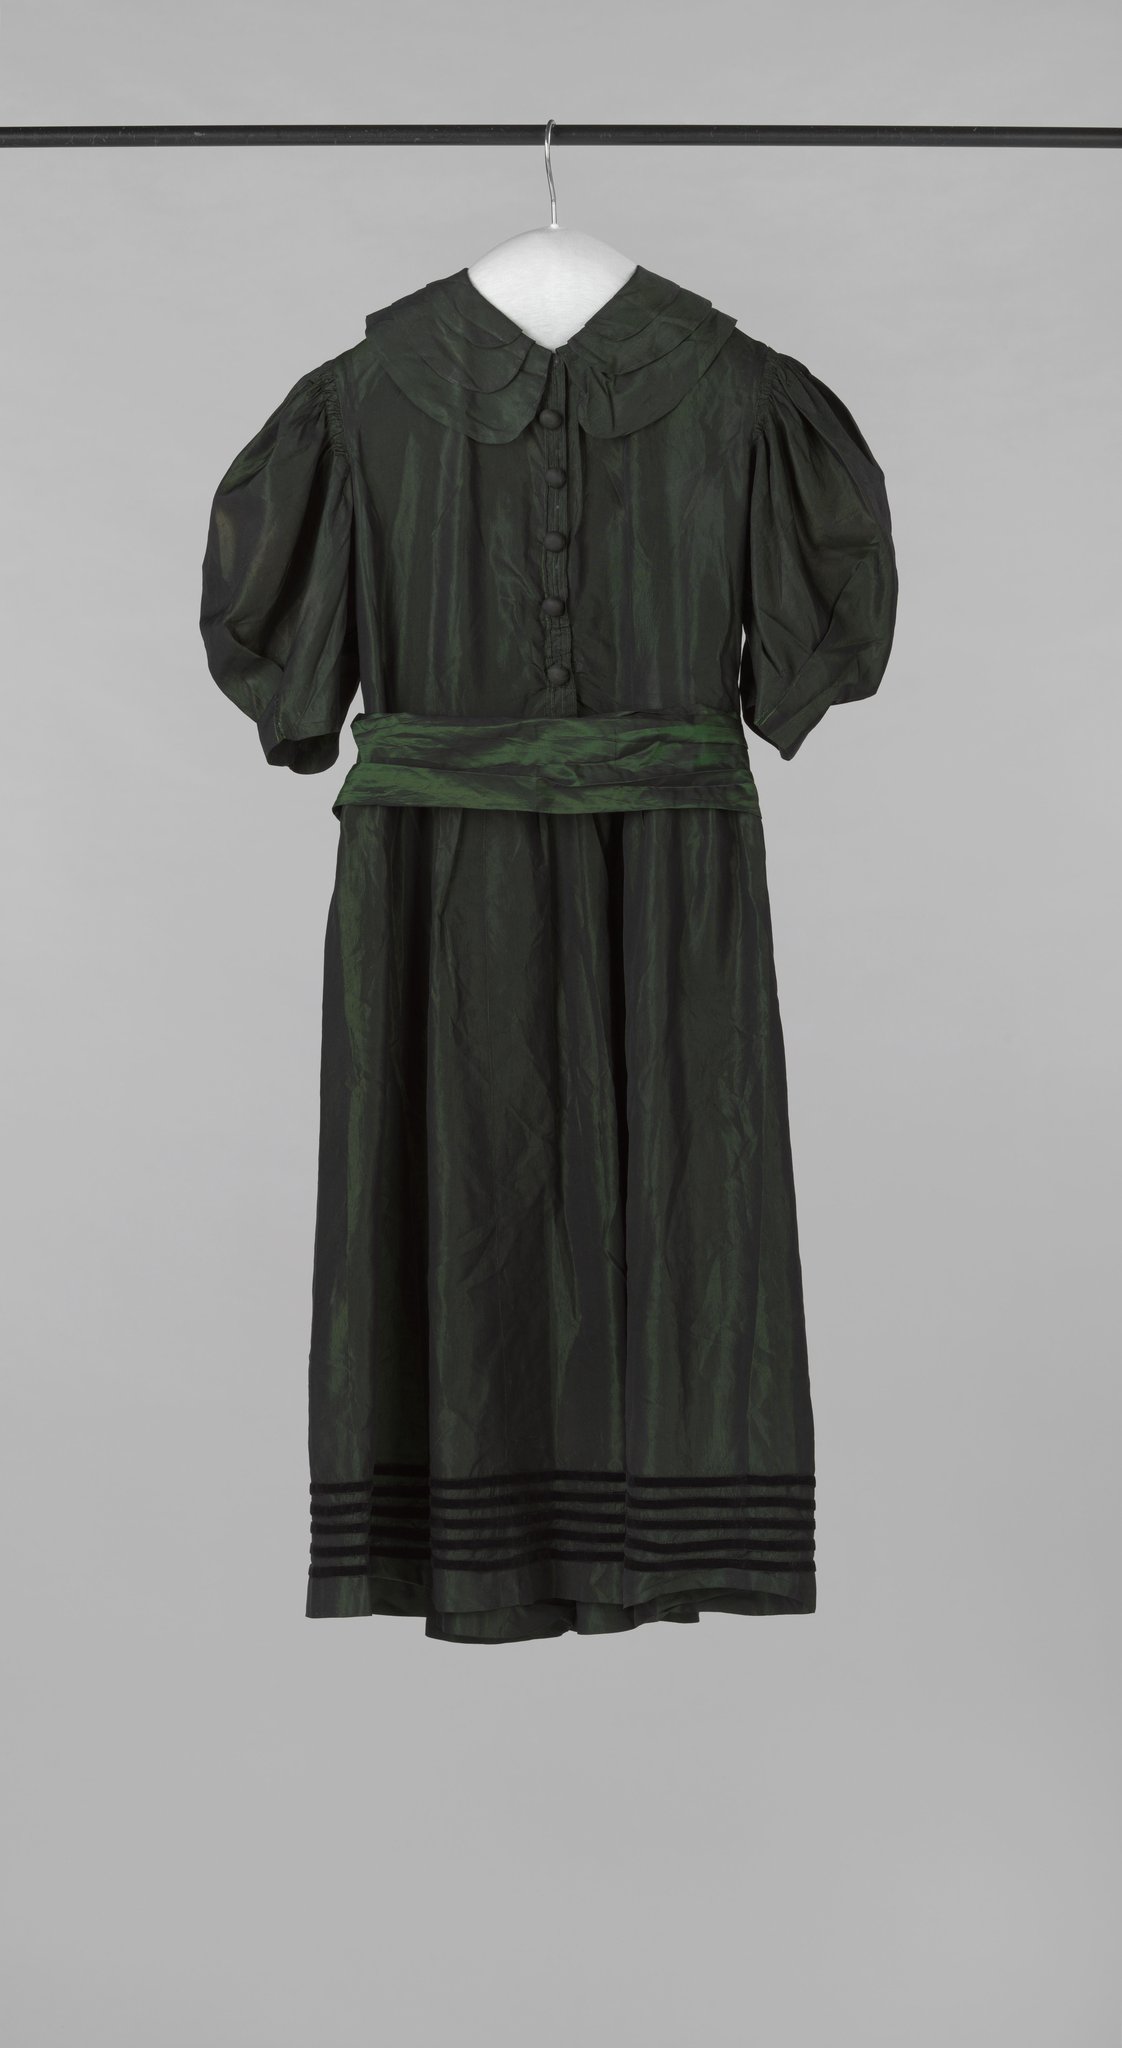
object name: childrenswear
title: Jurk van donkergroene tafzijde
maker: Anonymous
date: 1930-1950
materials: silk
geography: netherlands